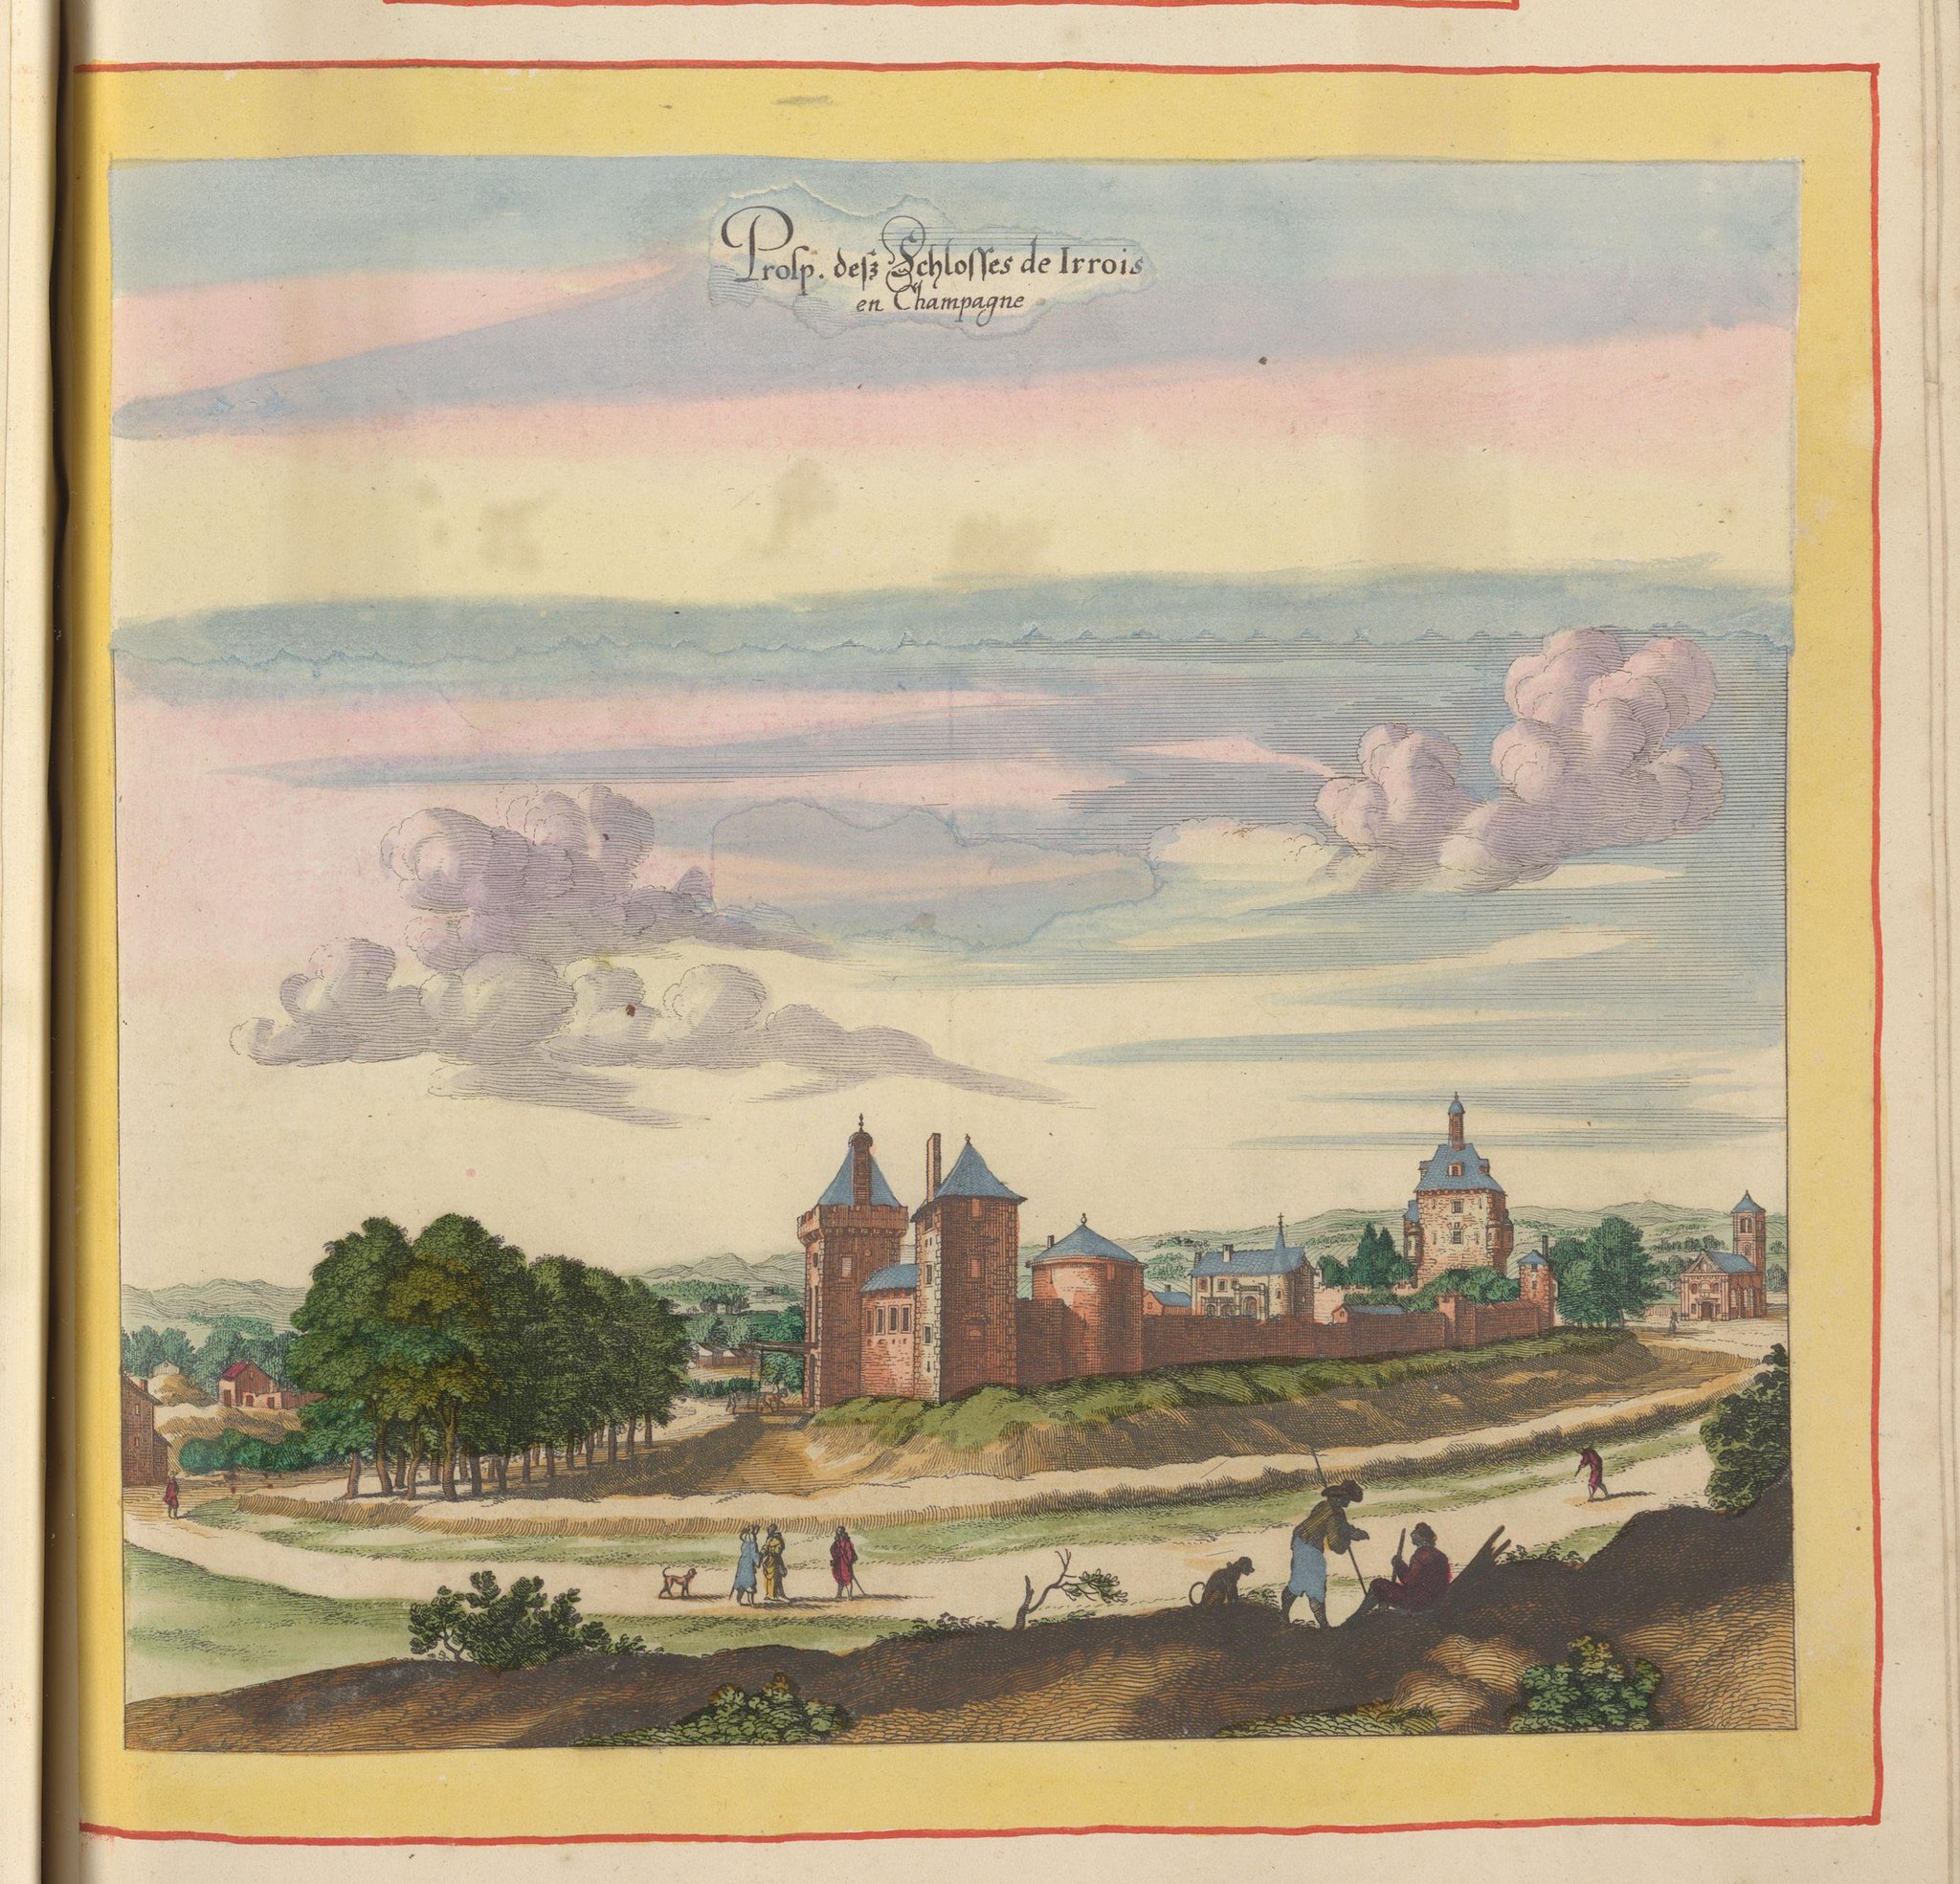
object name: print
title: Prosp. des Schlosses de Irrois, en Champagne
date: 1656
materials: paper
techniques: engraving, etching, hand coloring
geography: frankfurt am main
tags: castle, landscape with tower or castle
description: Prent uit: Zeiller, Martin. Topographia Galliae. 13 dln. Frankfurt: Caspar Merian, 1656, dl. 3, na p. 14.